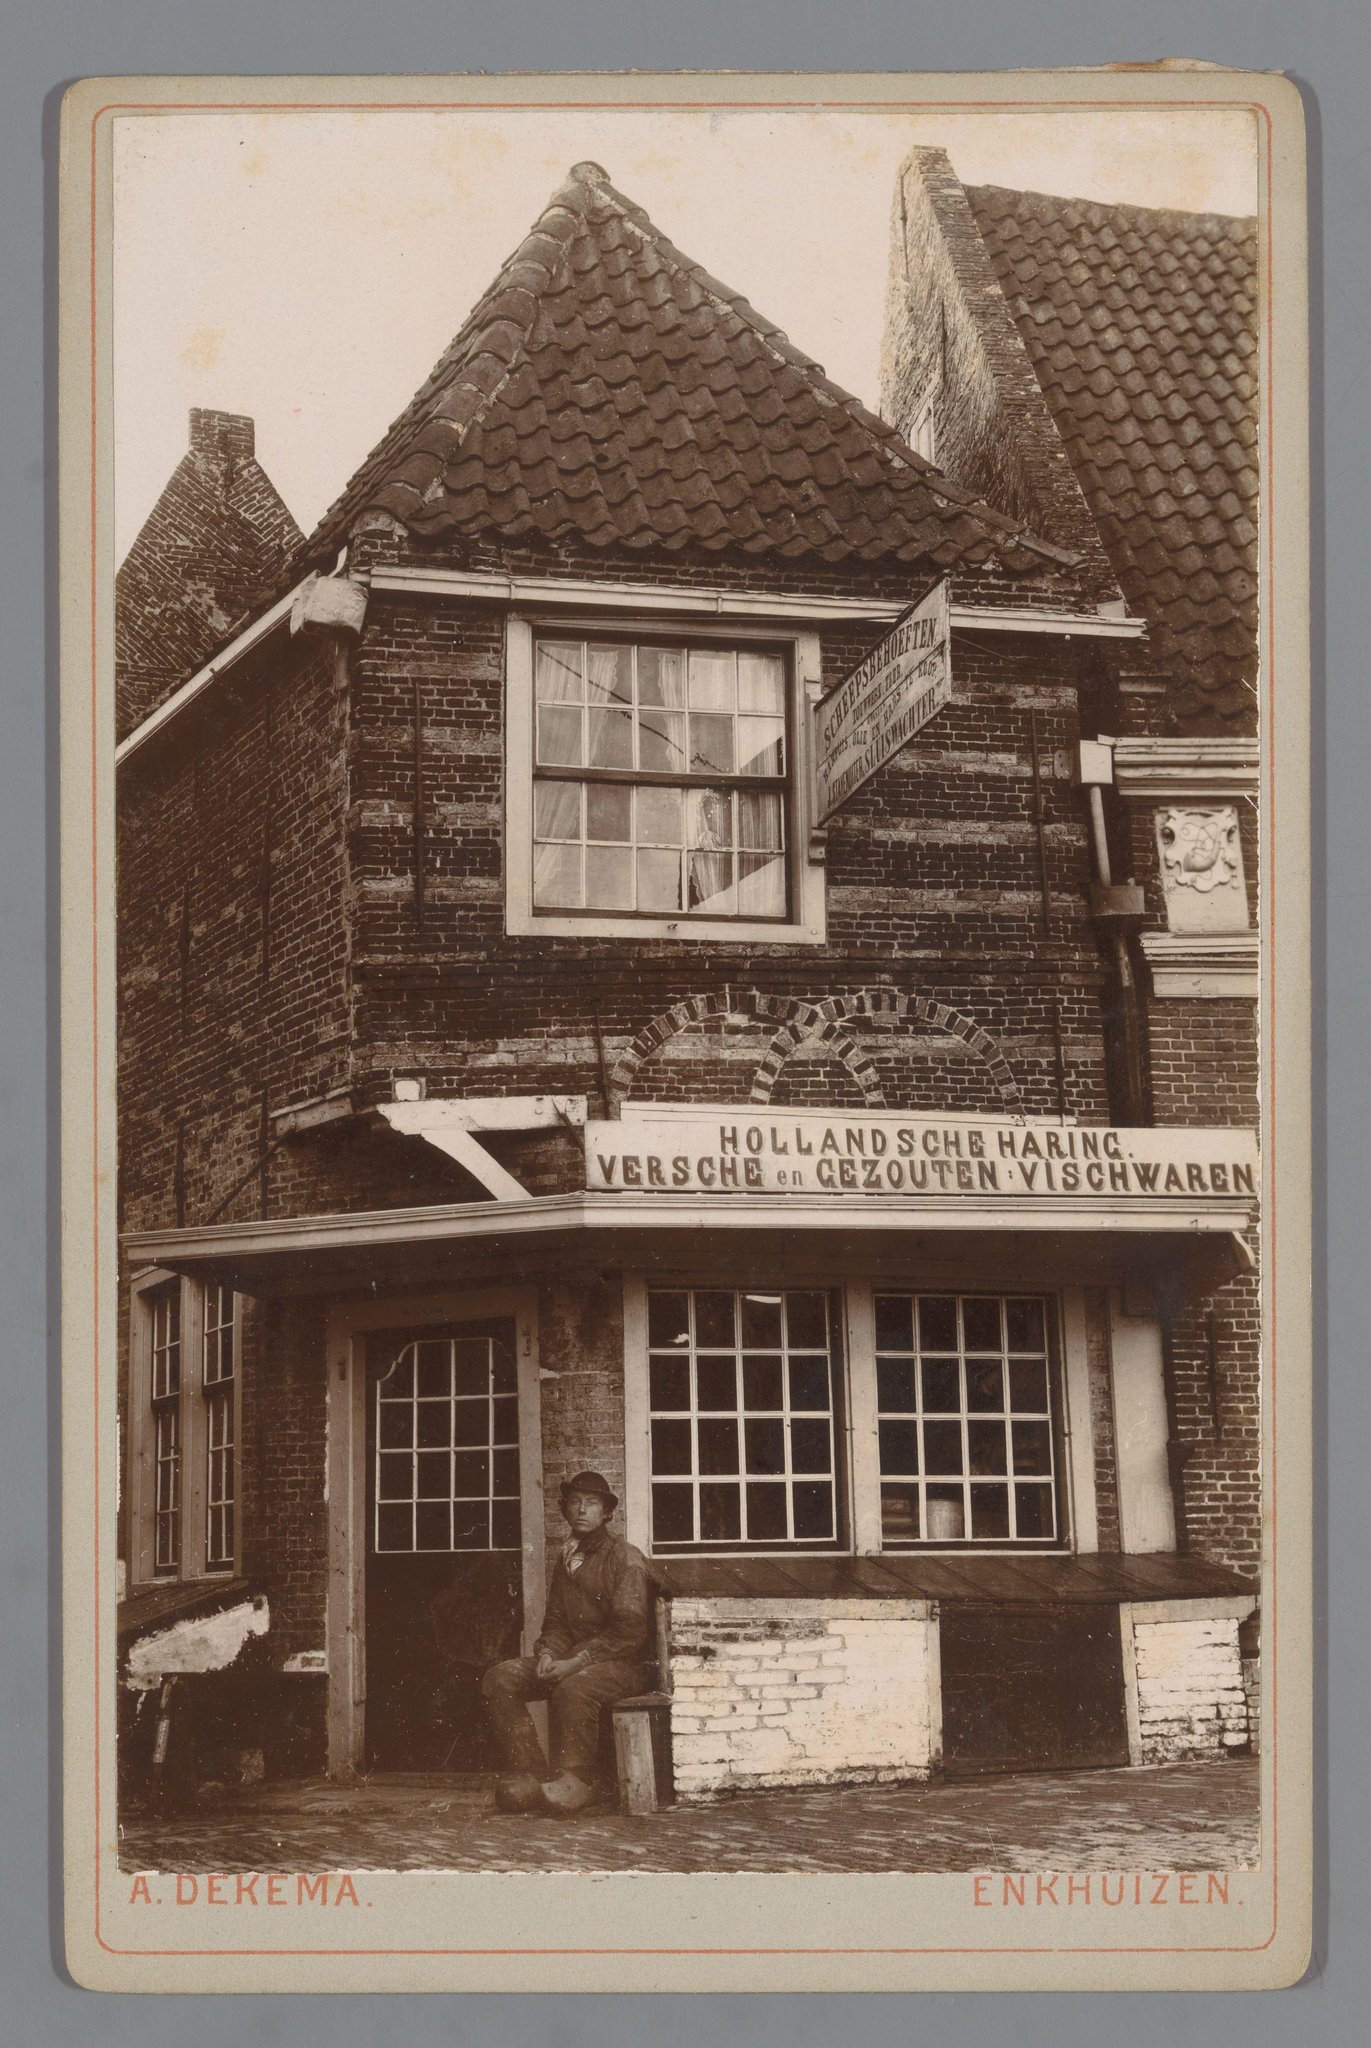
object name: photograph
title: Exterieur van een winkel met viswaren en scheepsbehoeften te Enkhuizen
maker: albert dekema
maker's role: publisher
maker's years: 1824-1909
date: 1900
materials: cardboard, photographic support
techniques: gelatin silver print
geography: enkhuizen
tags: shop, store, façade (of house or building)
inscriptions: inscription: ‘Enkhuizen’